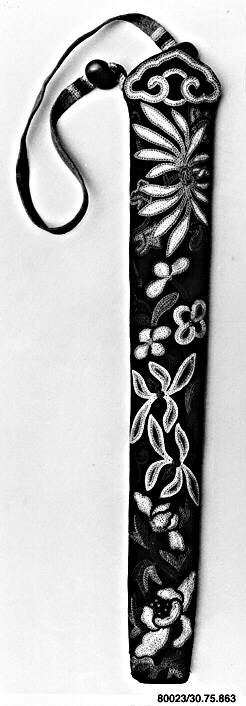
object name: fan holder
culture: chinese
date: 1701-1900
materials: silk